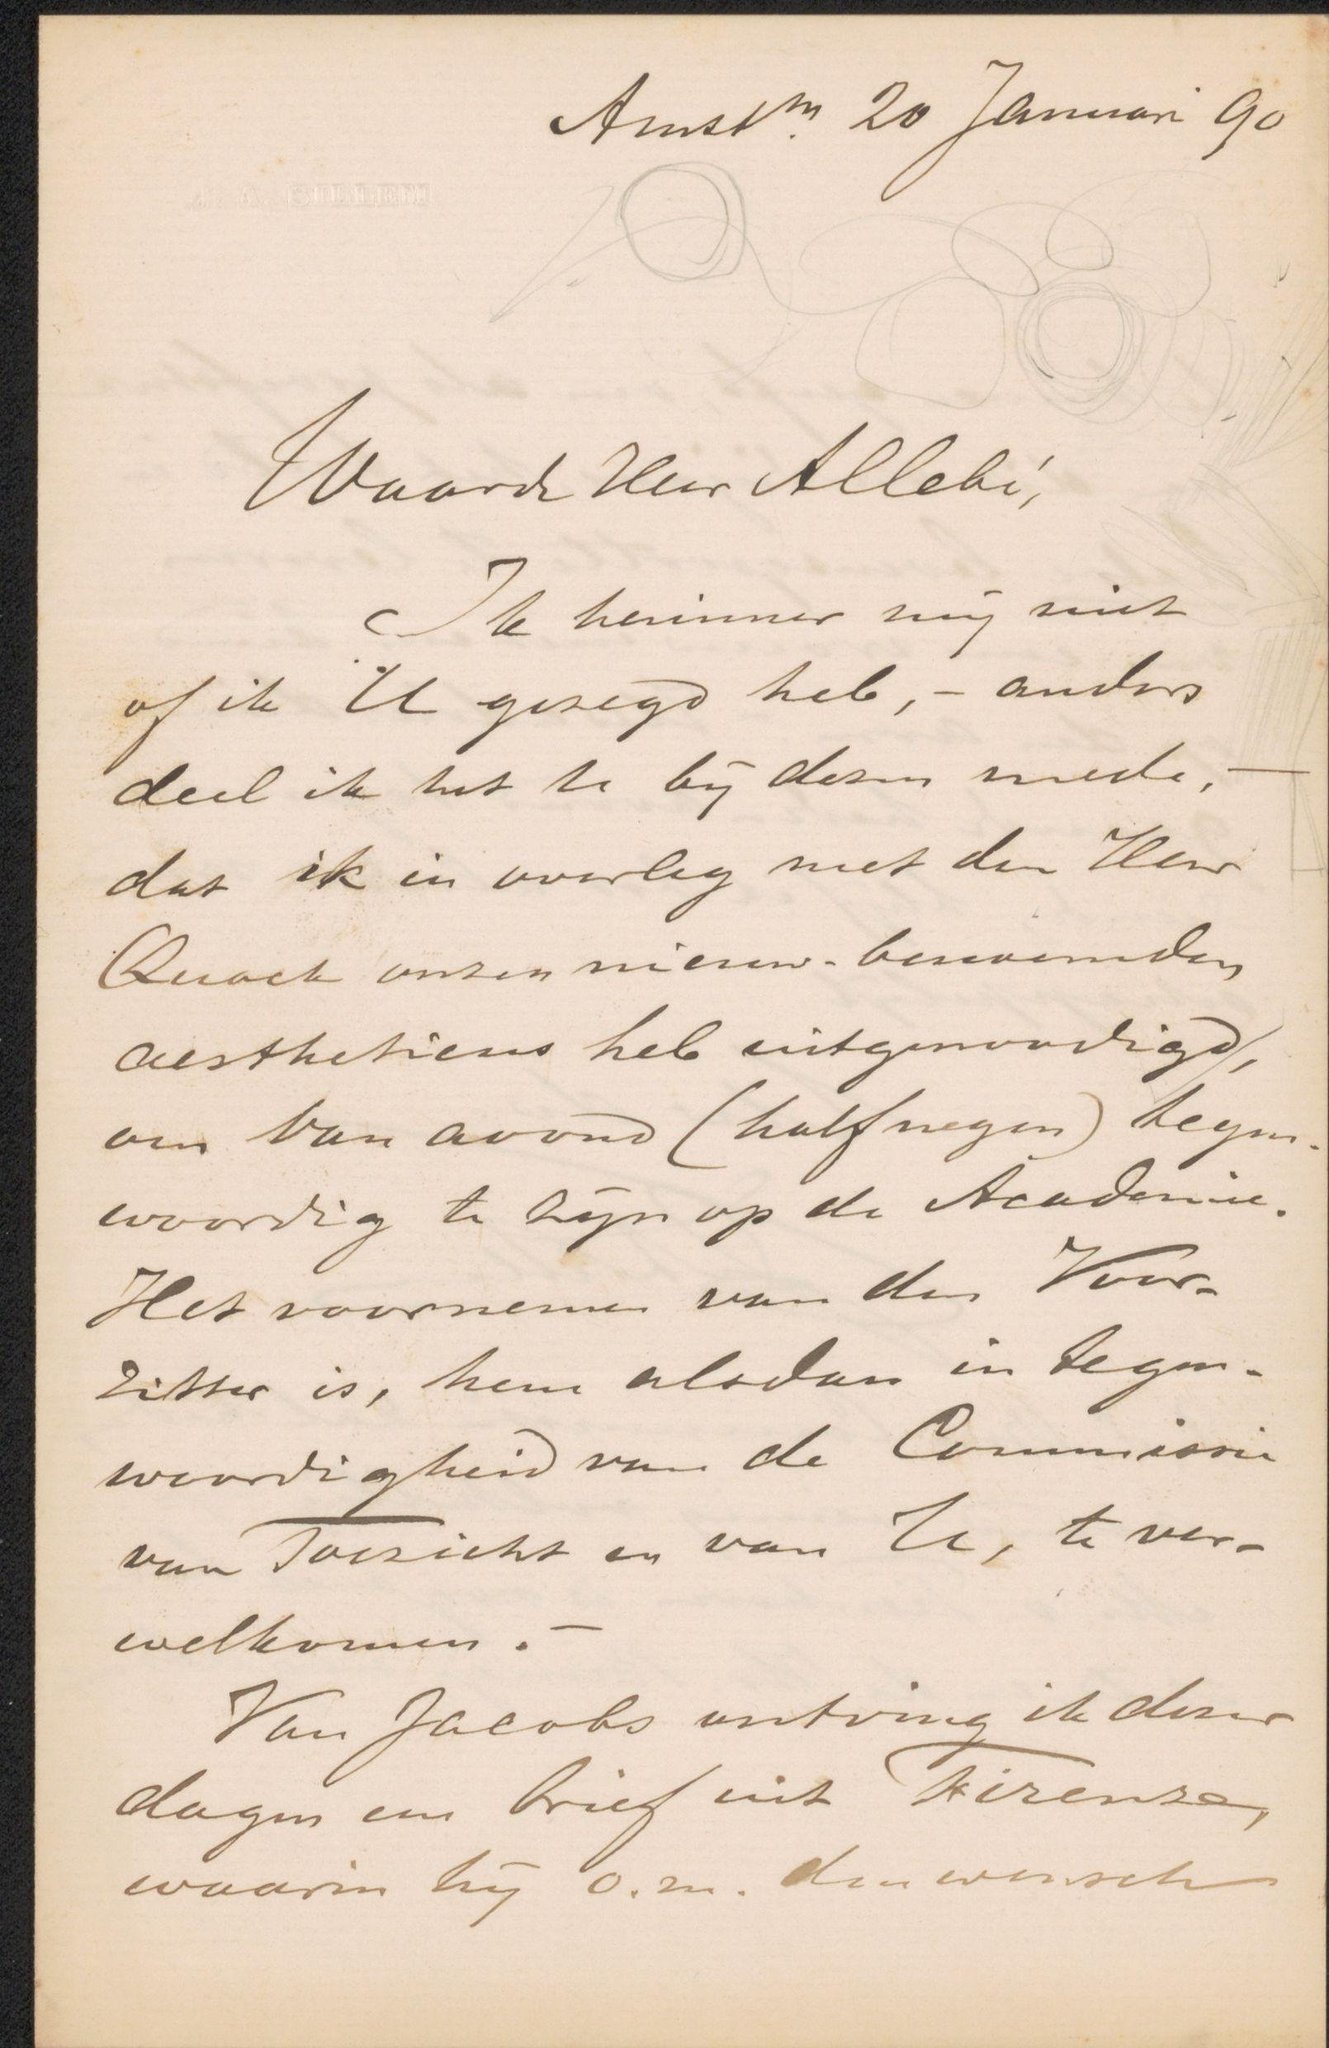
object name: letter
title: Brief aan August Allebé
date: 1890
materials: ink, paper, pencil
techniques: pen, printing, writing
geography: amsterdam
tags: print maker, draughtsman, august allebé, gijsbert van tienhoven, hendrick peter godfried quack, sculptor, sculpture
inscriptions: name: ‘J.A. SILLEM’